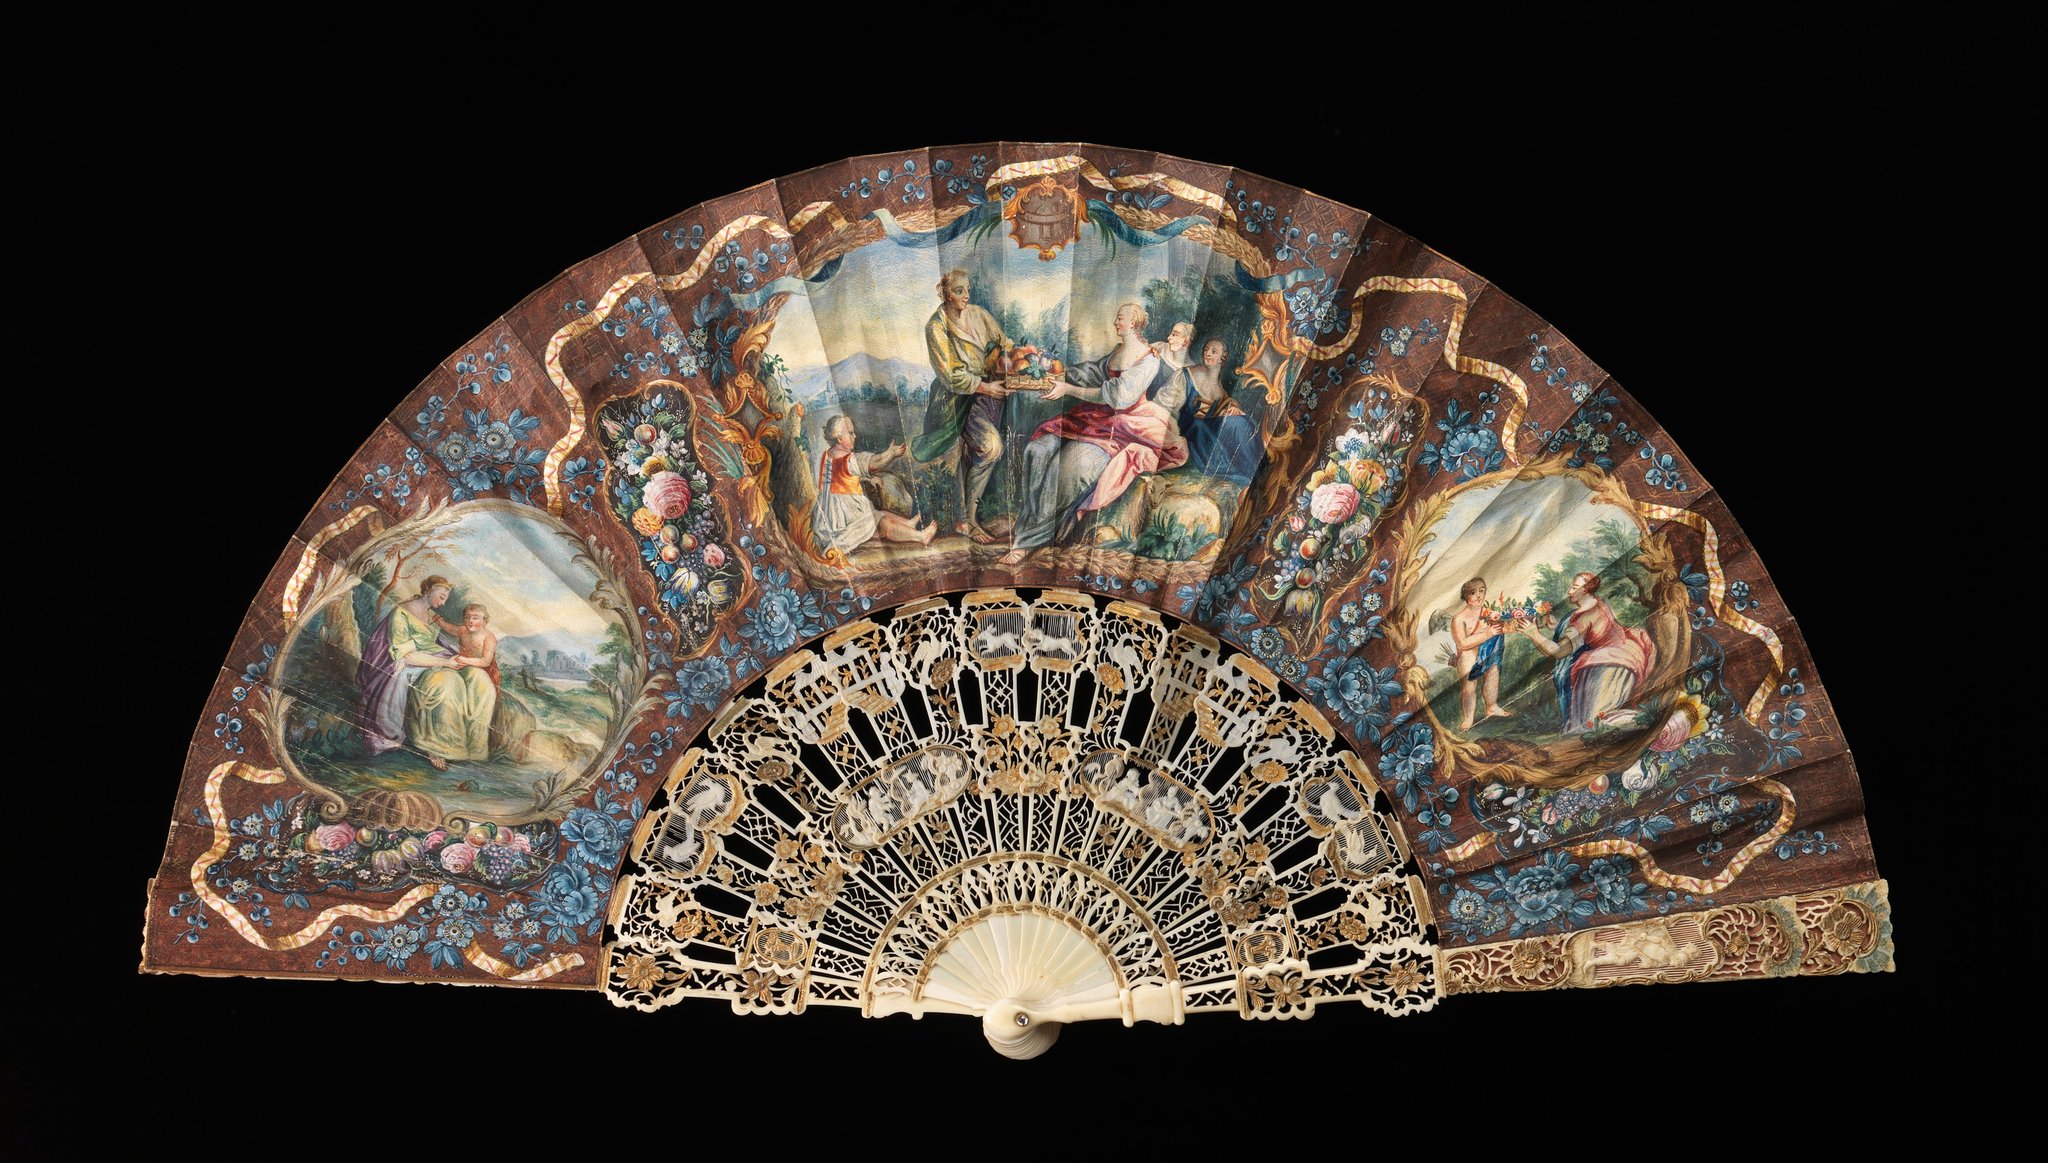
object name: fan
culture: dutch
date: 1751-1775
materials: gouache, ivory, metal, parchment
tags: men,women,roses